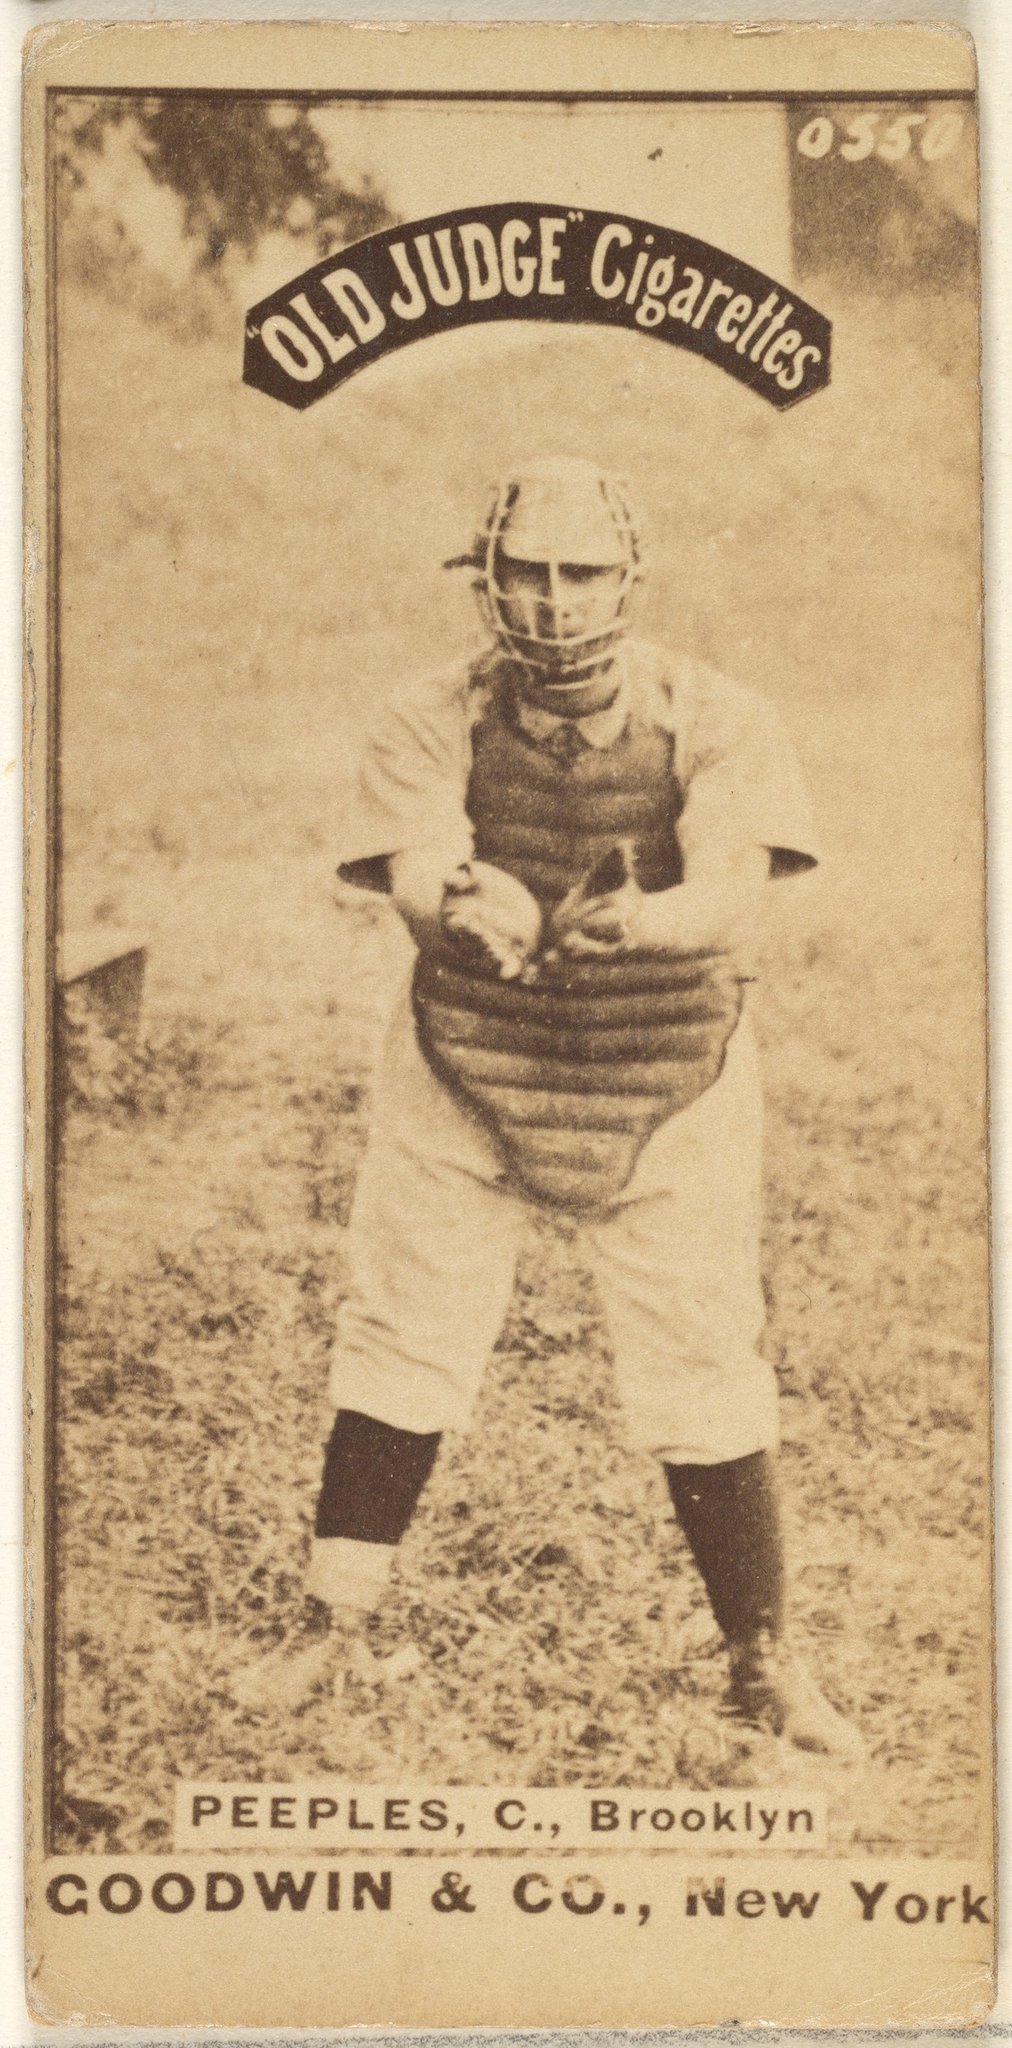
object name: baseball card, photograph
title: Peeples, Catcher, Brooklyn, from the Old Judge series (N172) for Old Judge Cigarettes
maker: goodwin & company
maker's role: publisher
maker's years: 1850-1950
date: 1887-1890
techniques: albumen silver print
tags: men,portraits,baseball,athletes